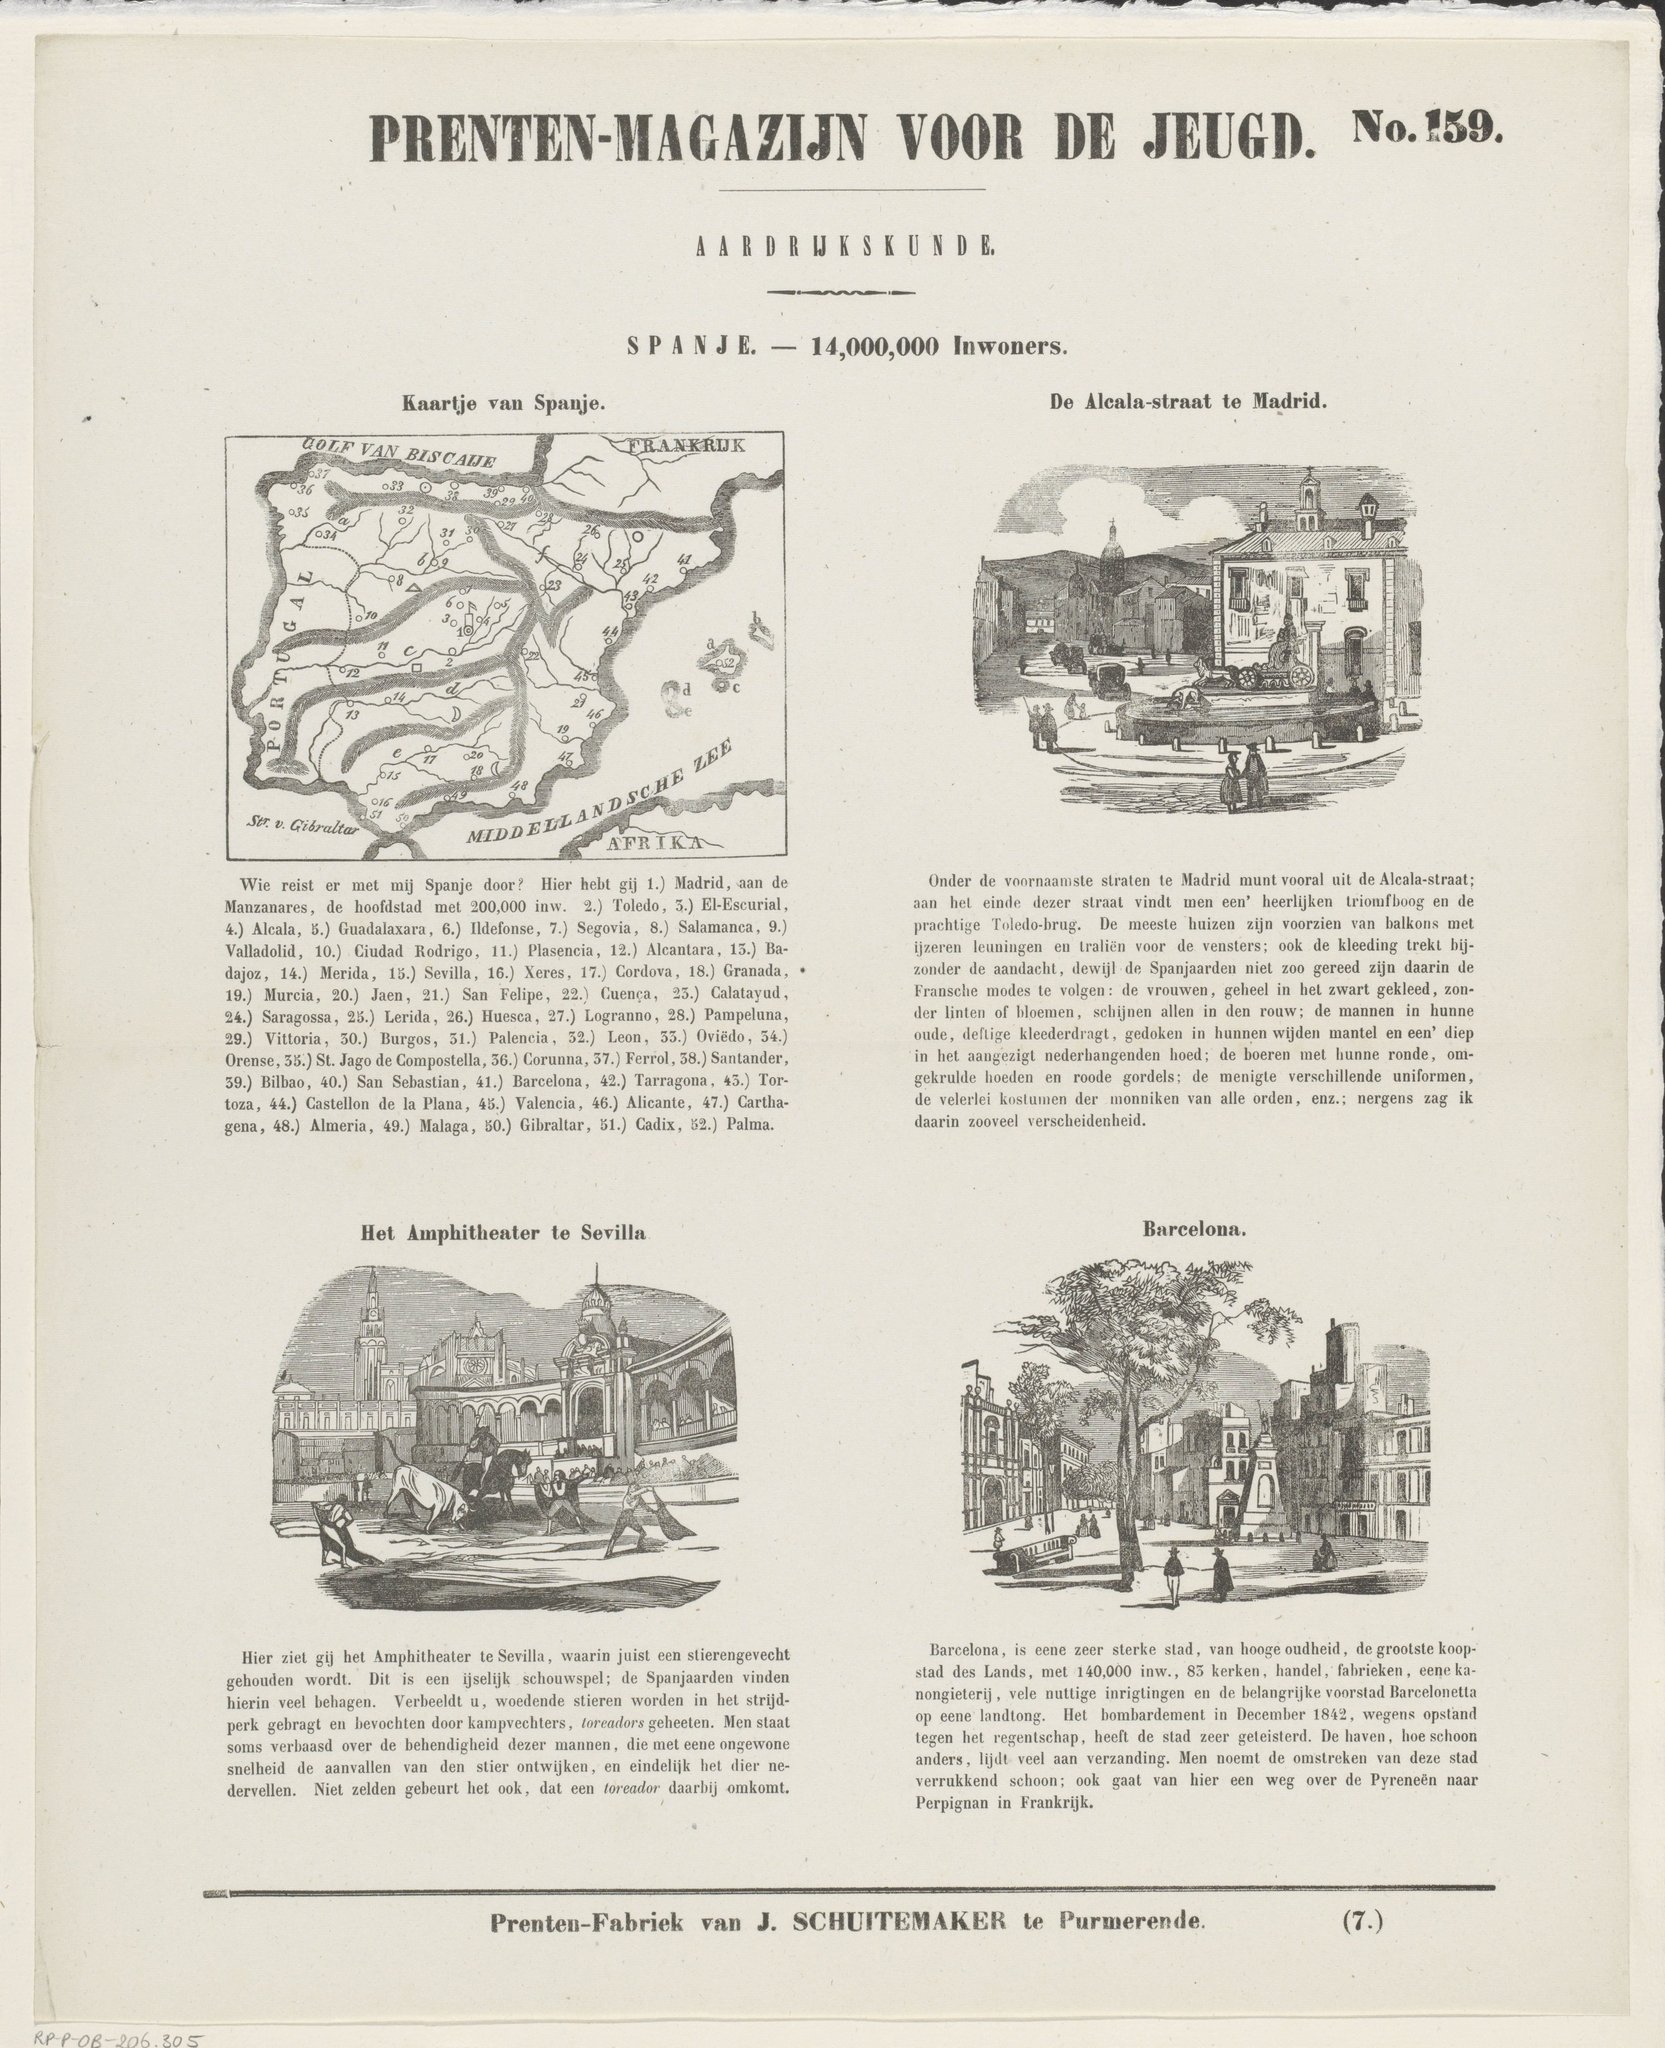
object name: print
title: Spanje. - 14,000,000 inwoners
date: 1850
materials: paper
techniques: letterpress printing, engraving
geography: purmerend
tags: buildings for performances, maps, atlases, sevilla, spain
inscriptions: collector's mark: Lugt 2760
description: Na voltooiing van de acht jaargangen van de reeks 'Prenten-magazijn voor de jeugd' in 1850 heeft Jan Schuitemaker al deze prenten heruitgegeven en omgenummerd als nr. 1 t/m 192. De oorspronkelijke jaargang wordt telkens nog vermeld rechtsonder op de prent. Binnen de jaargangen zijn prenten van hetzelfde thema in clusters van vier achter elkaar gezet.